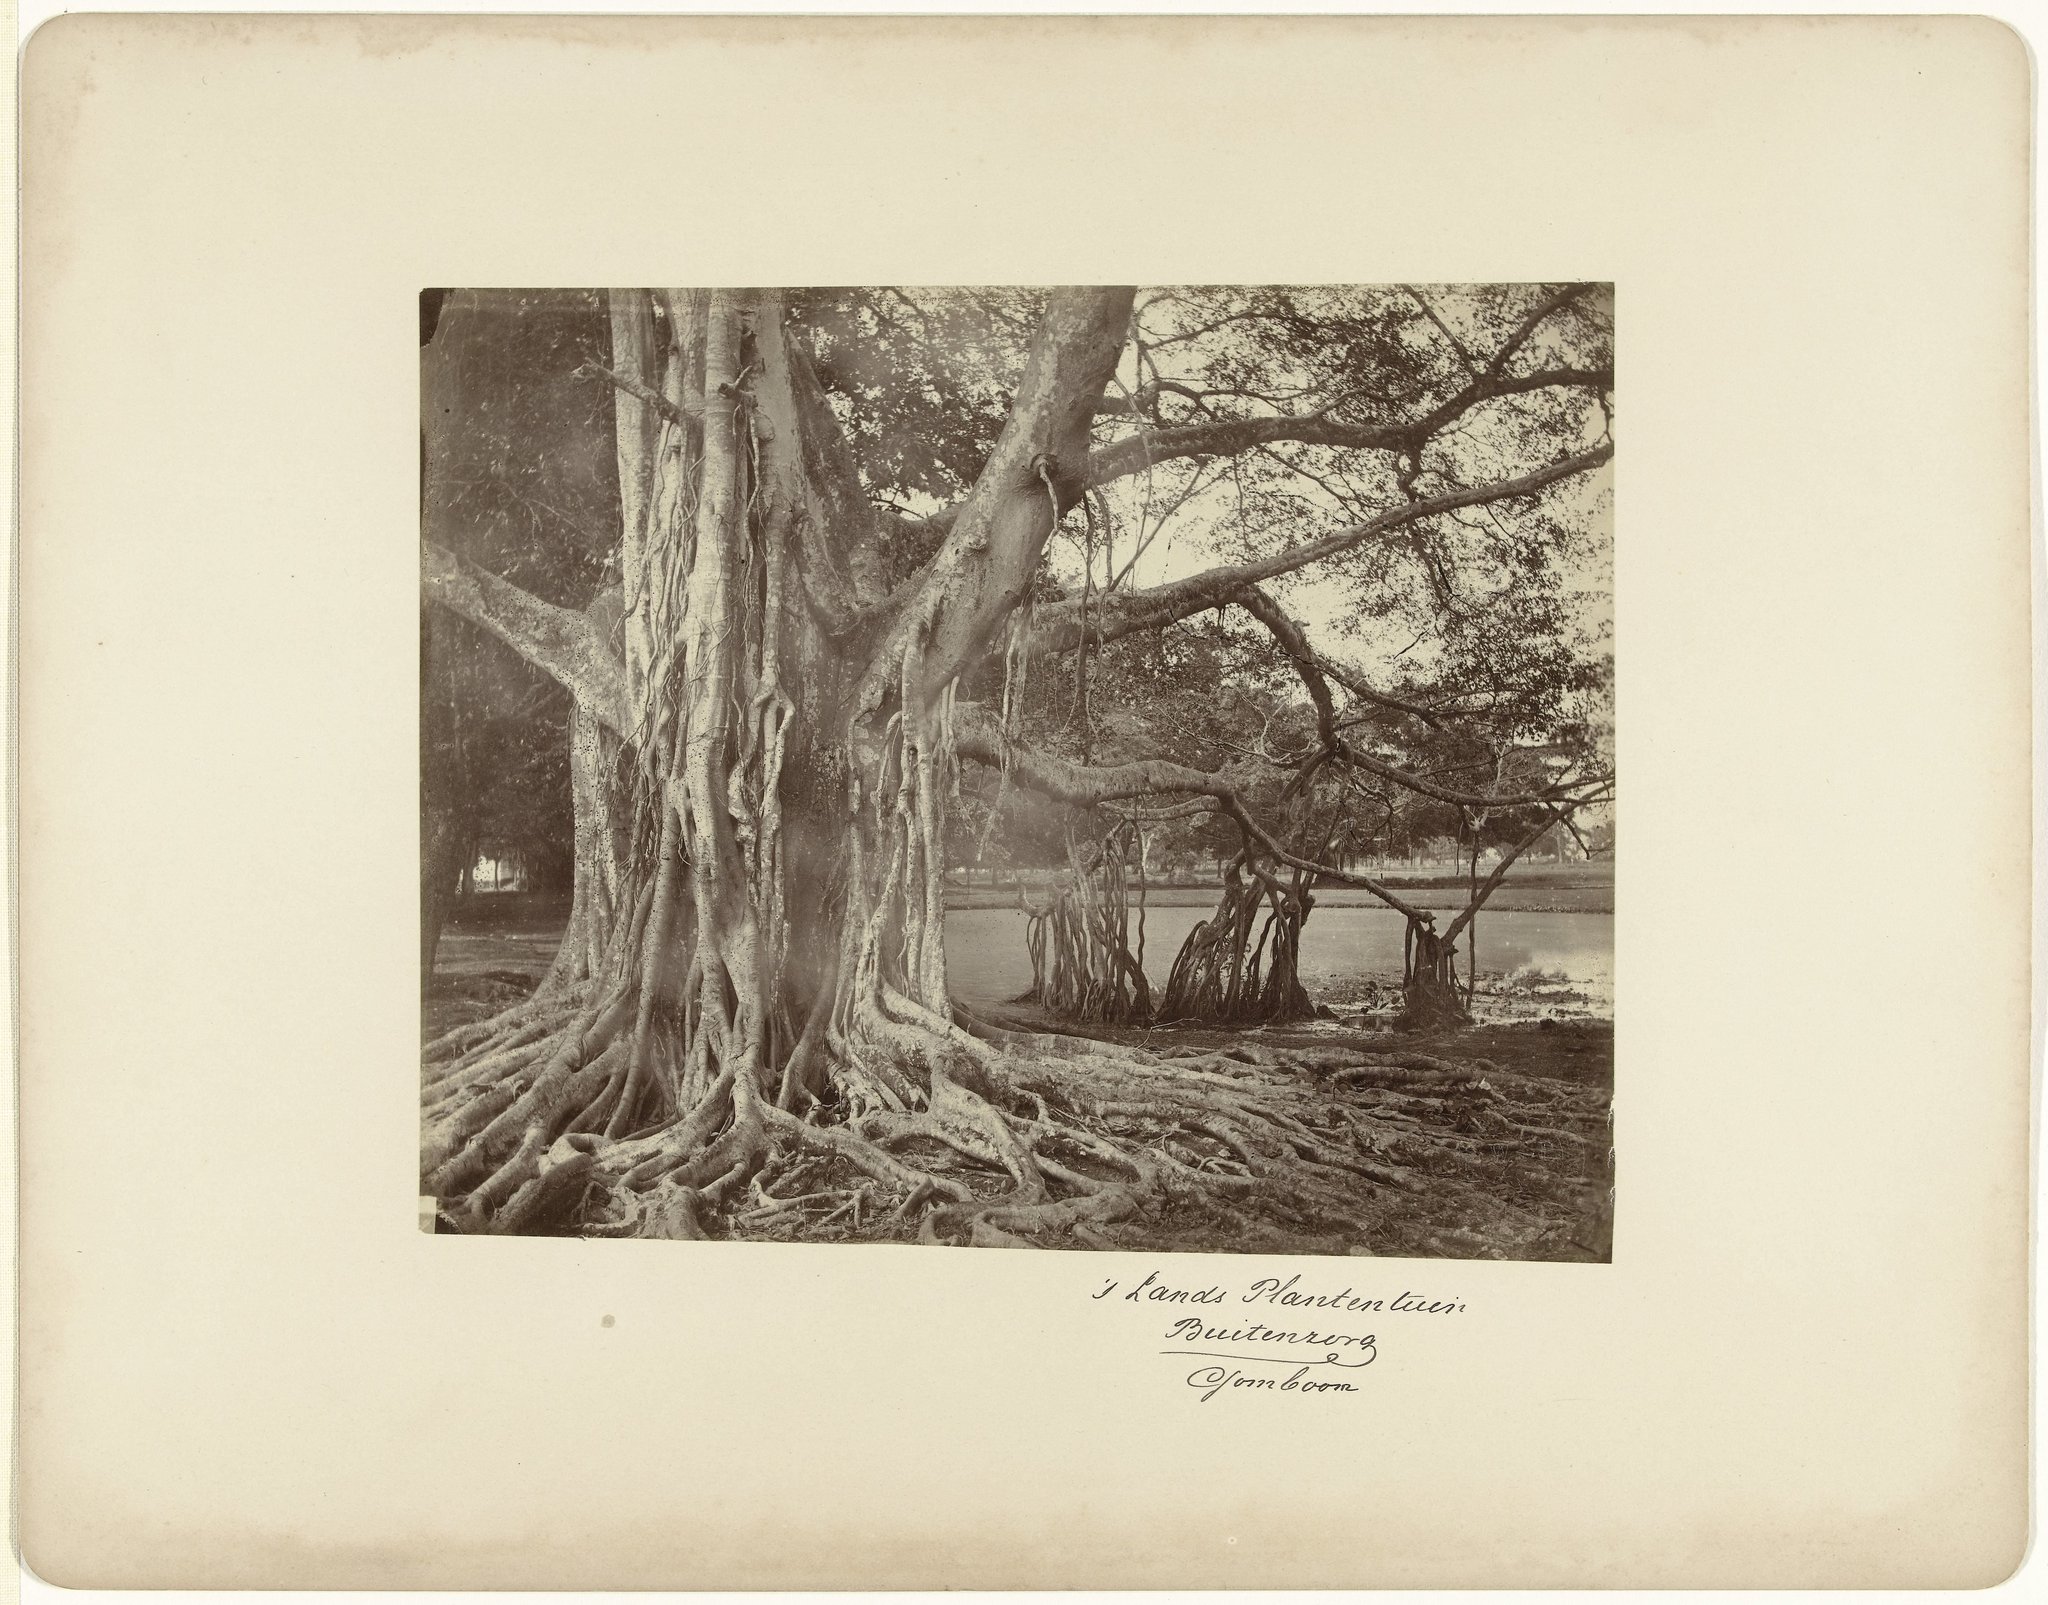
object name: photograph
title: Gomboom in de Plantentuin van paleis Buitenzorg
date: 1870-1908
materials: cardboard, paper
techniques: albumen print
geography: buitenzorg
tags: trees, botanic garden, 'hortus botanicus'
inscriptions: check stamp: ‘Photographieen van Ned. Indië/ W & P/ Batavia’, inscription: ‘'s Lands Plantentuin/ Buitenzorg/ Gomboom’